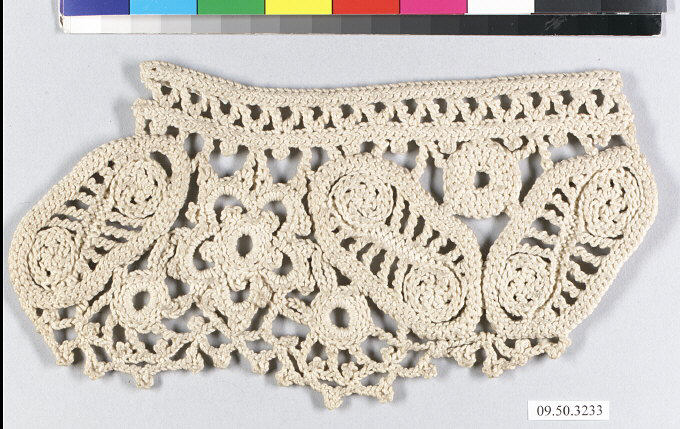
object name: sample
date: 1801-1900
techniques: crochet